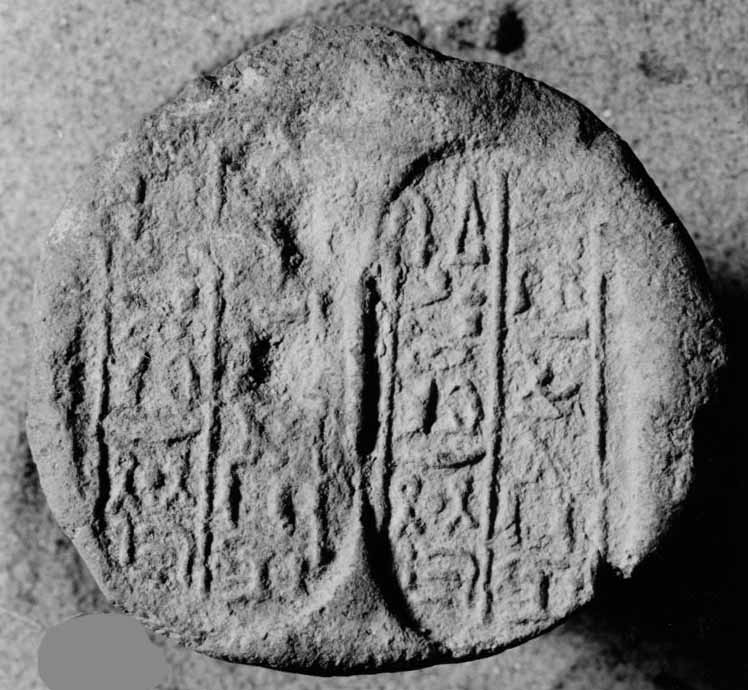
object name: cone, oval stamp, tjay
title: Funerary Cone of the Chief of the Merchants Tjay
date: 1550-1295 BCE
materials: pottery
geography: egypt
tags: hieroglyphs